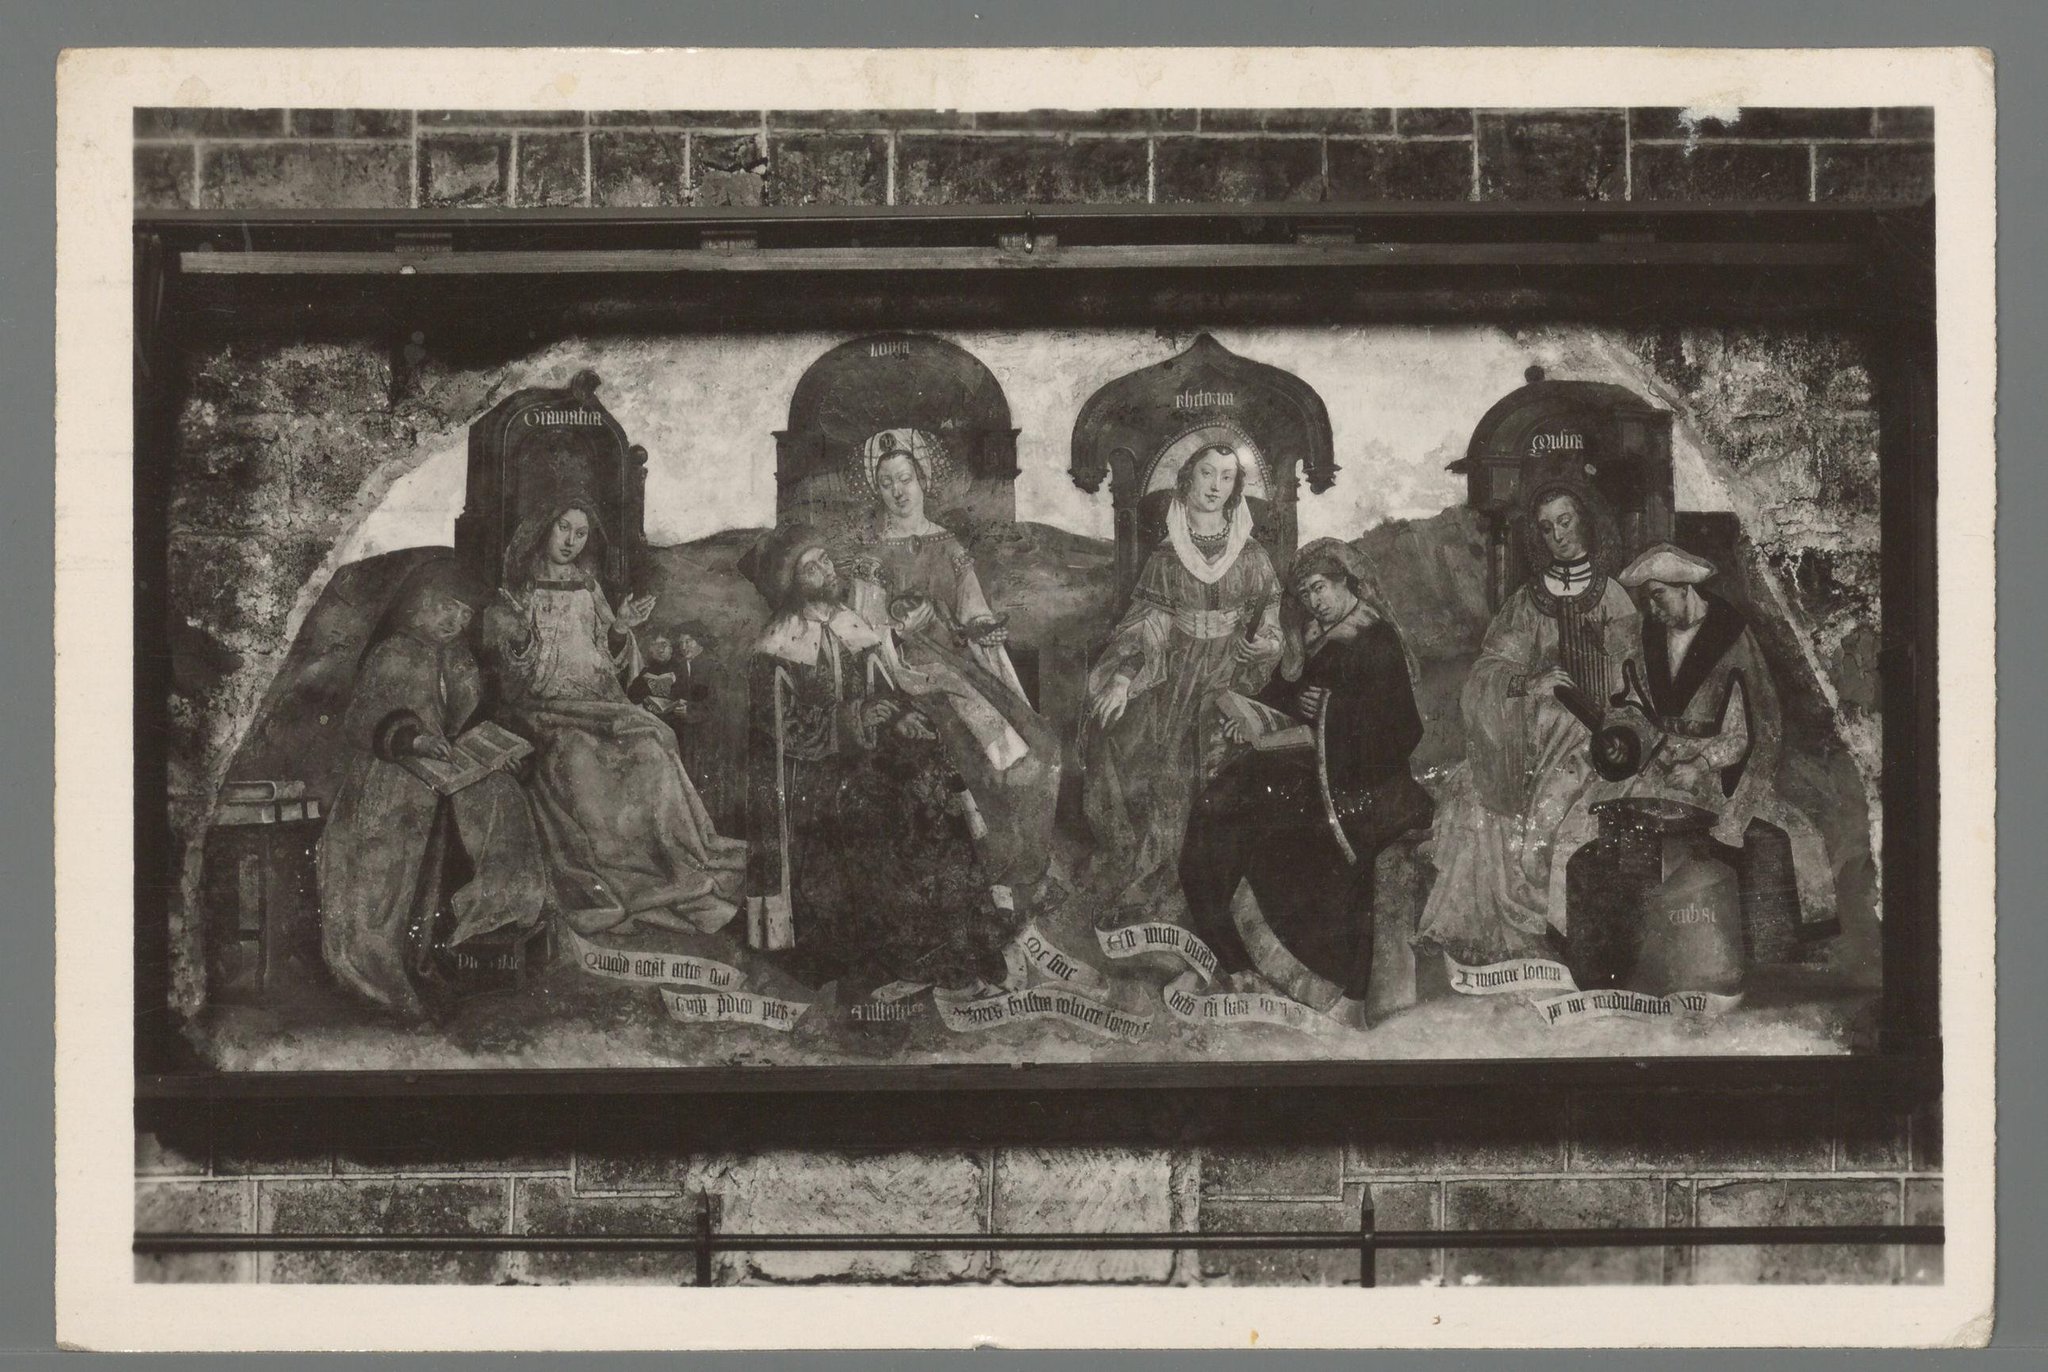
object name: ansichtkaart, prentbriefkaart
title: Le Puy (H.-L.) - Fresque des Arts. Chapelle des Reliques dans la Cathédrale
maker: Anonymous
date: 1930-1951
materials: photographic support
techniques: photography, writing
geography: le puy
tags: interior of church, picture, painting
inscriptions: postage stamp